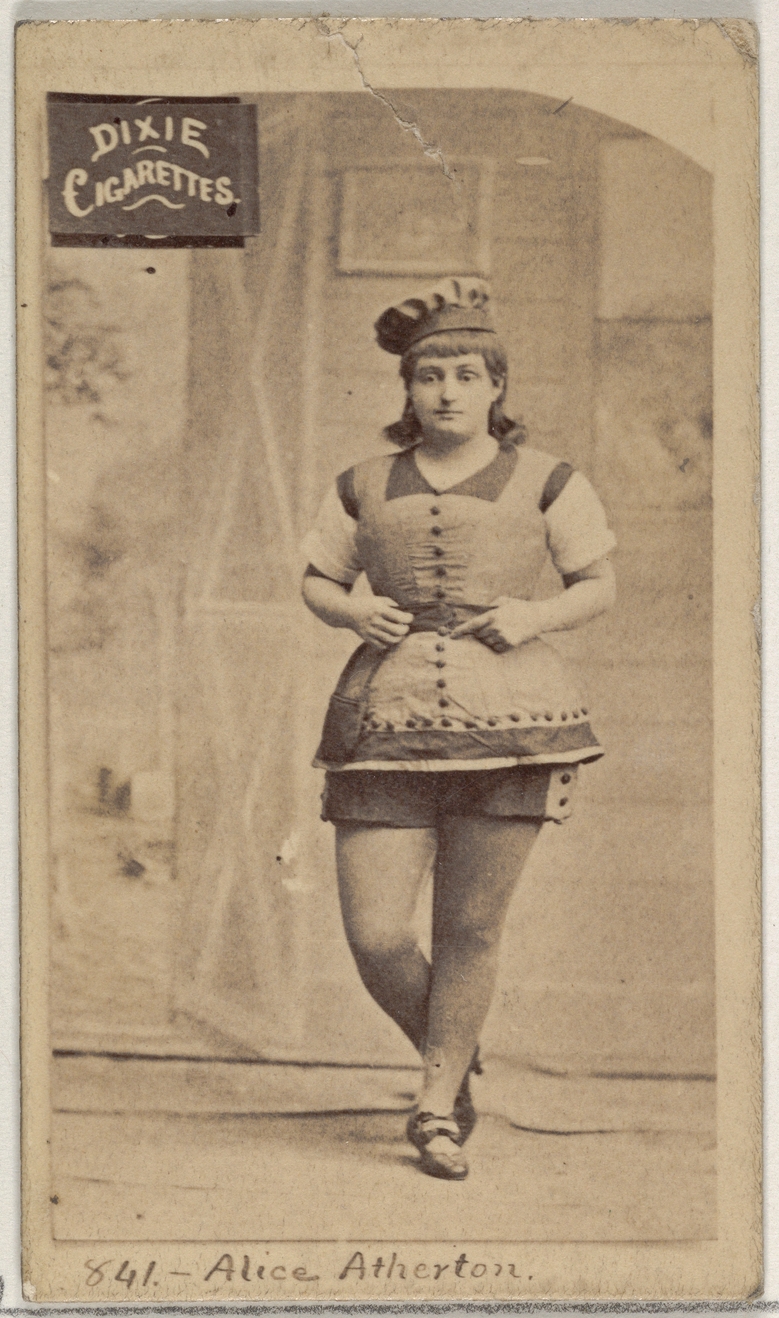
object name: photograph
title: Card 841, Alice Atherton, from the Actors and Actresses series (N45, Type 7) for Dixie Cigarettes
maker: allen & ginter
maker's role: publisher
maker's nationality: american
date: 1888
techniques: albumen silver print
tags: portraits,women,actresses